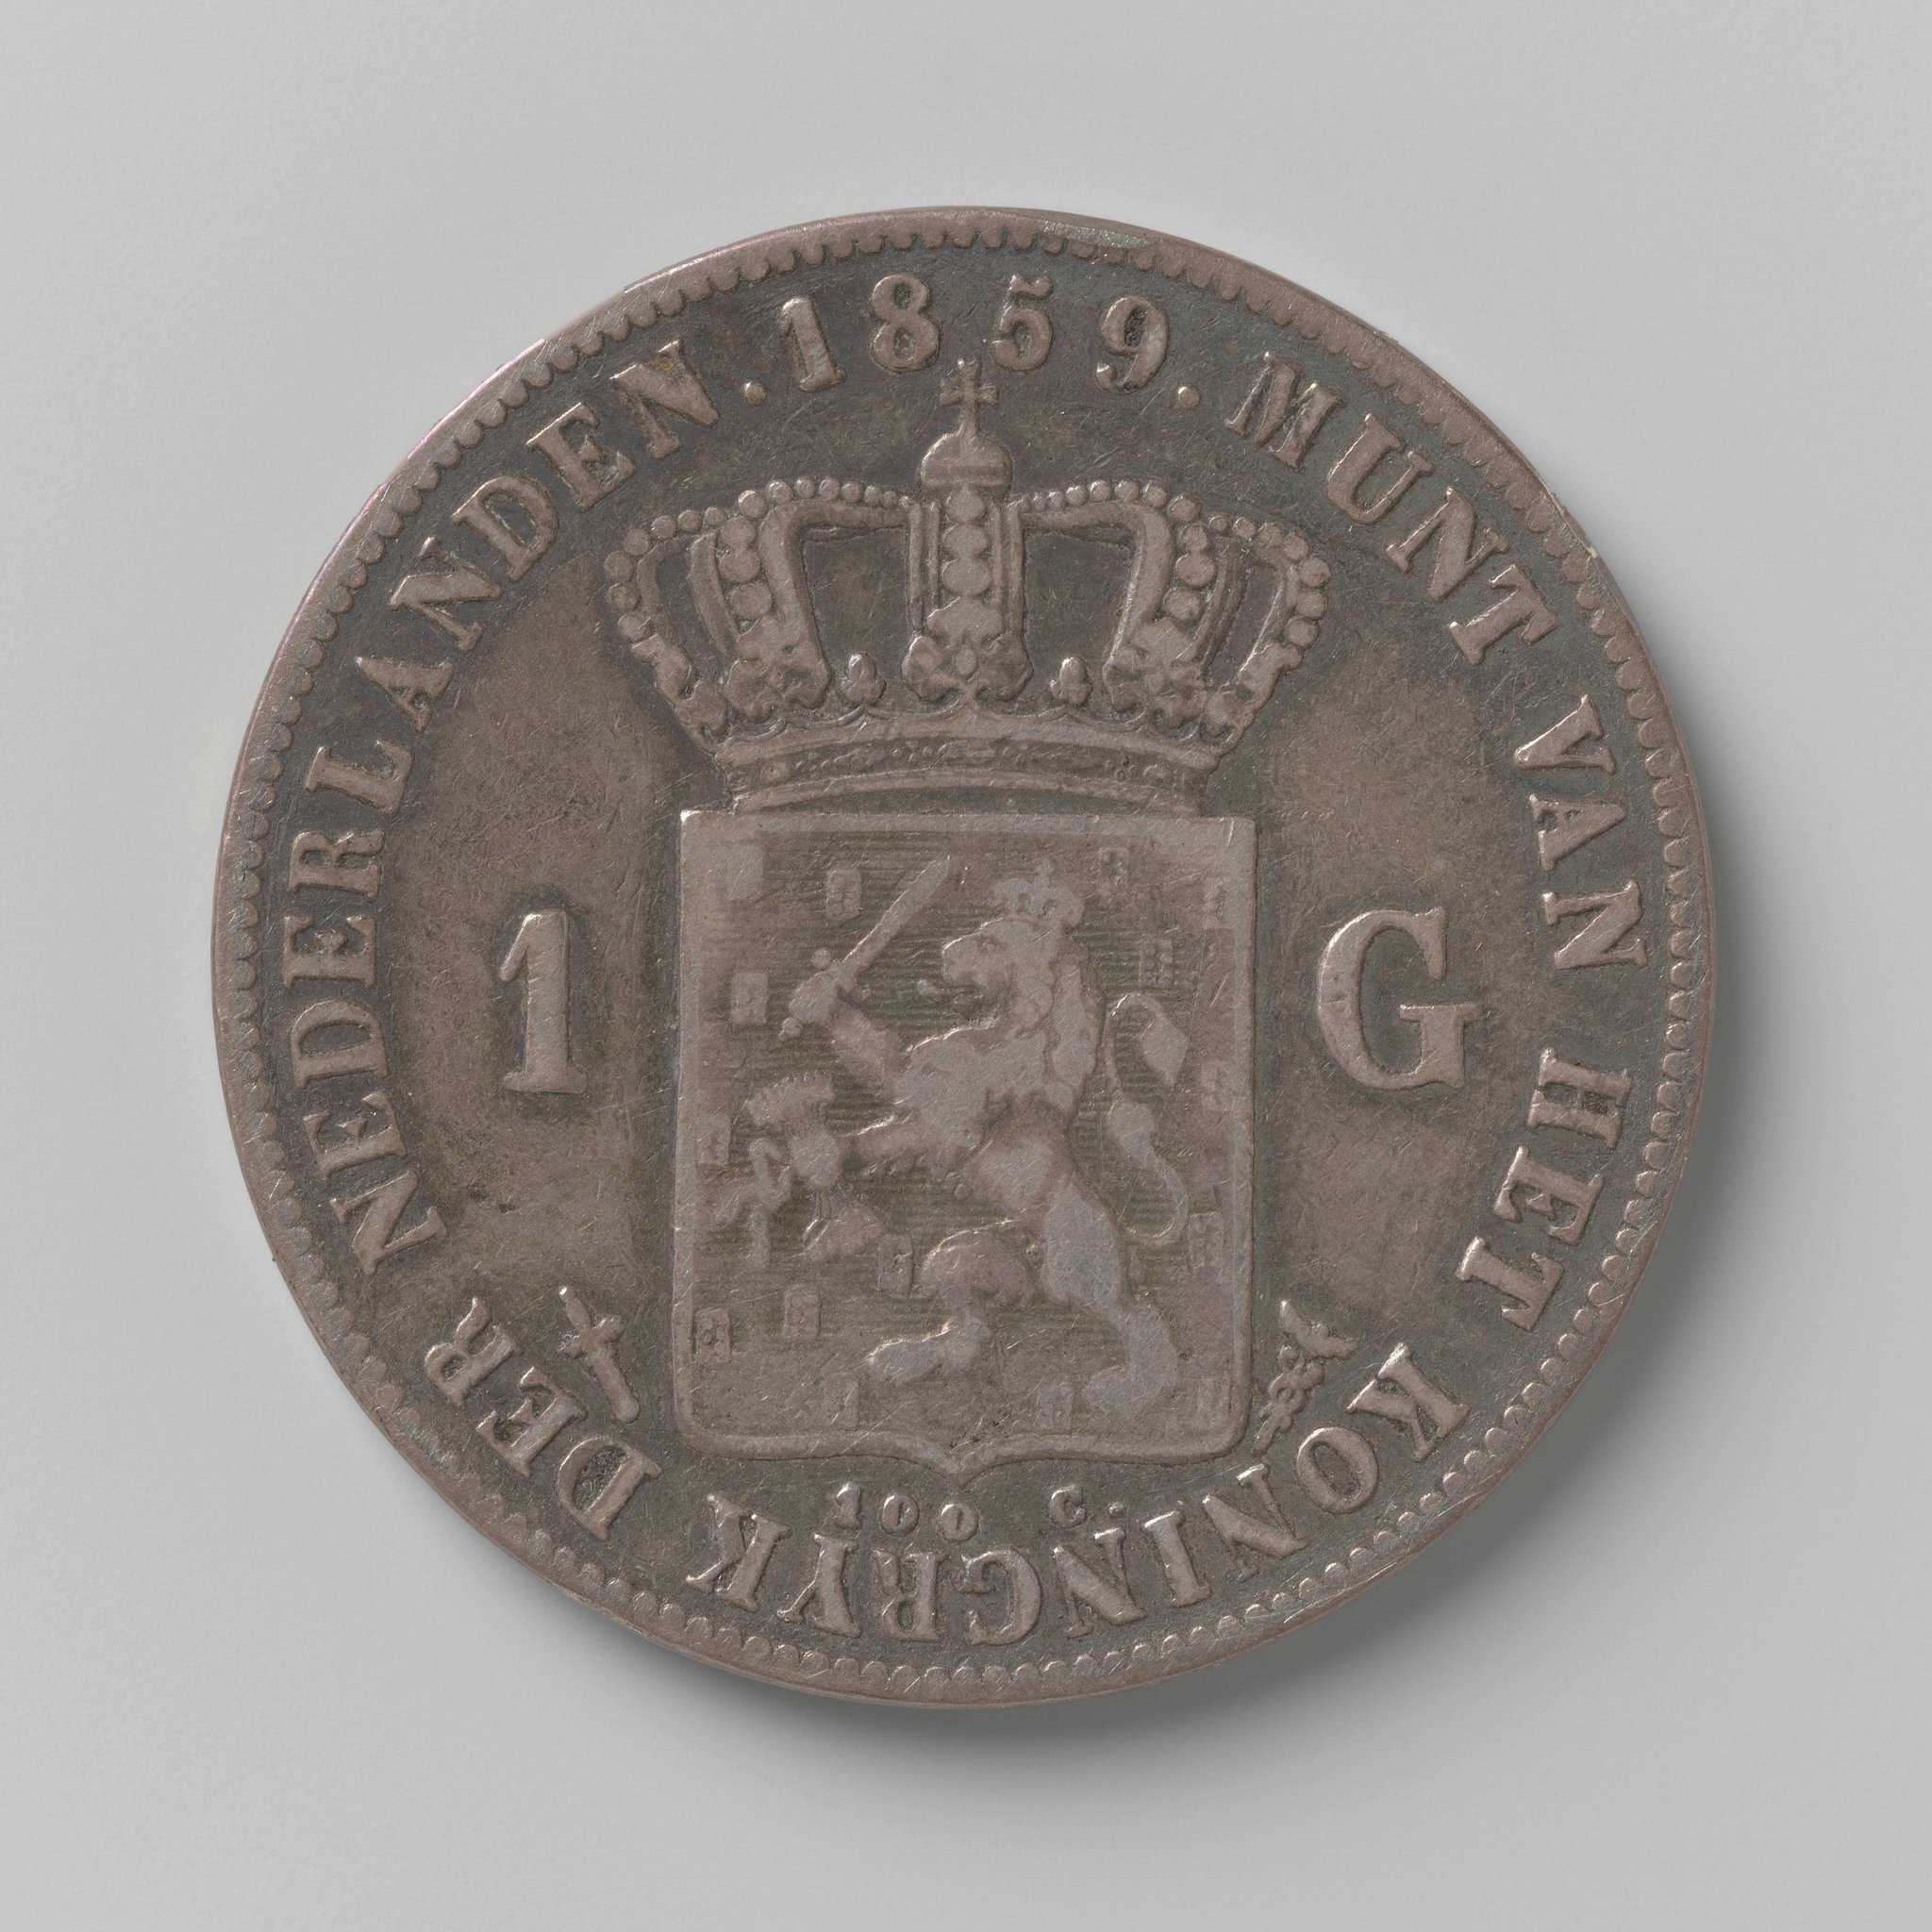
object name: coin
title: Nederlandse gulden, 1859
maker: willem iii (koning der nederlanden)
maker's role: koning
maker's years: 1817-1890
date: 1859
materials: silver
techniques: striking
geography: utrecht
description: Zilveren munt. Voorzijde: borstbeeld naar rechts. Keerzijde: tussen waarde-aanduiding 1 G gekroond rijkswapenschild. Jaartal boven kroon. Randschrift.